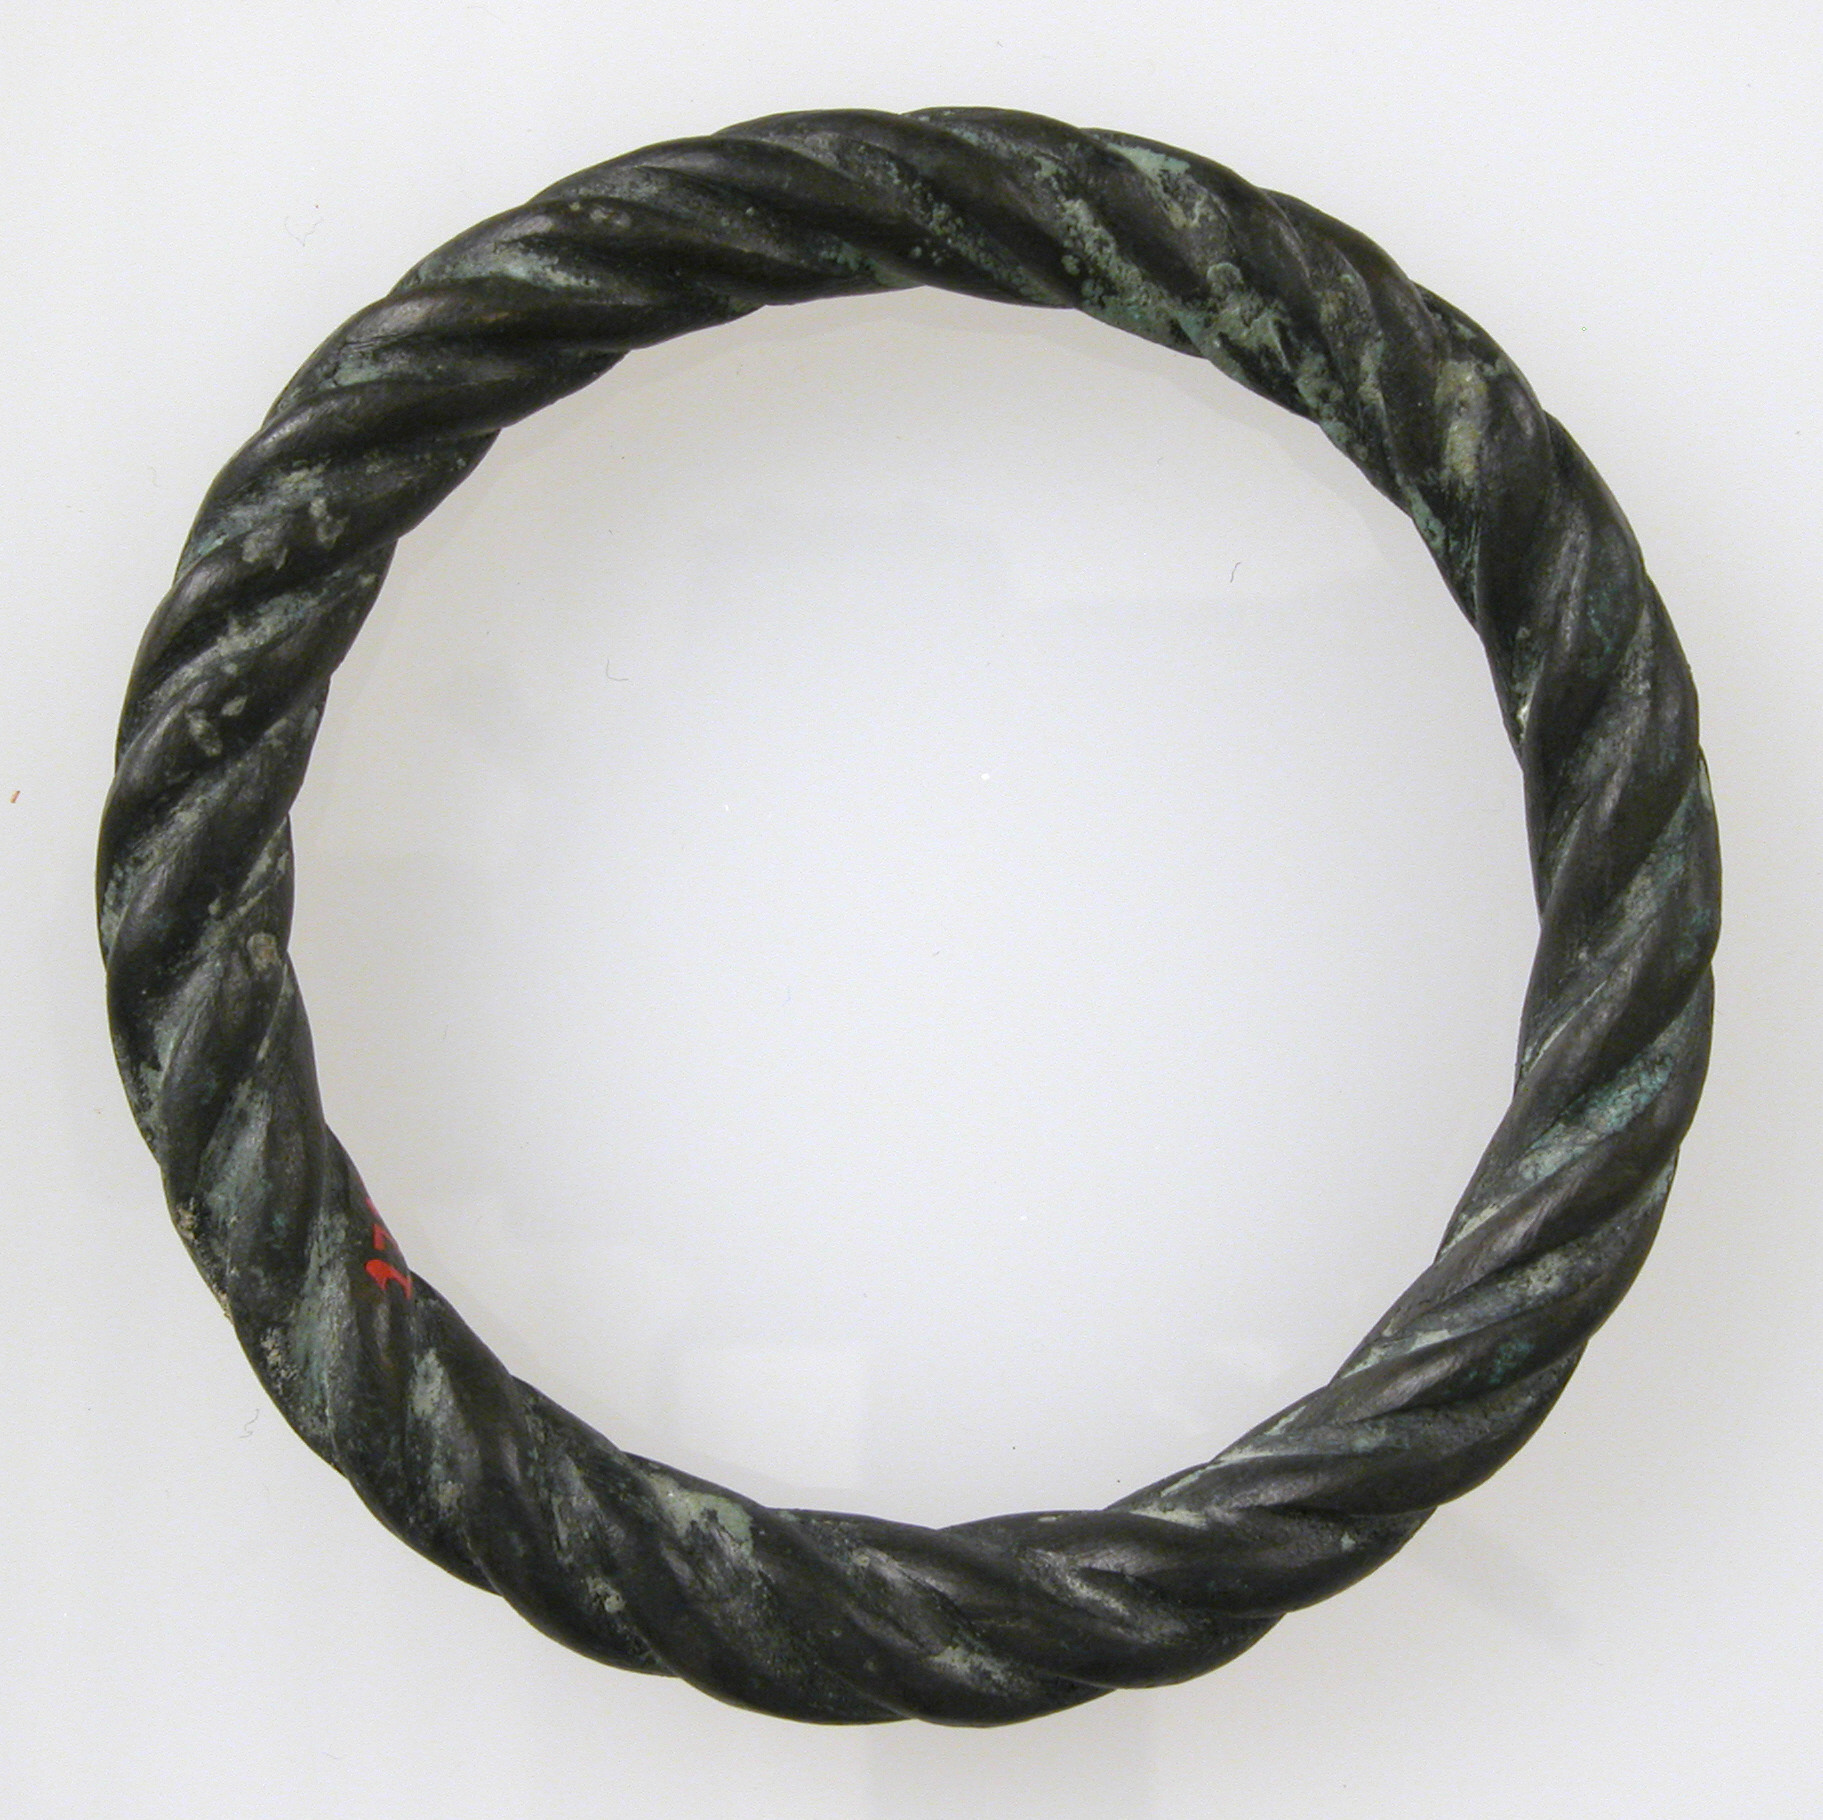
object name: bracelet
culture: celtic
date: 300 BCE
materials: copper alloy